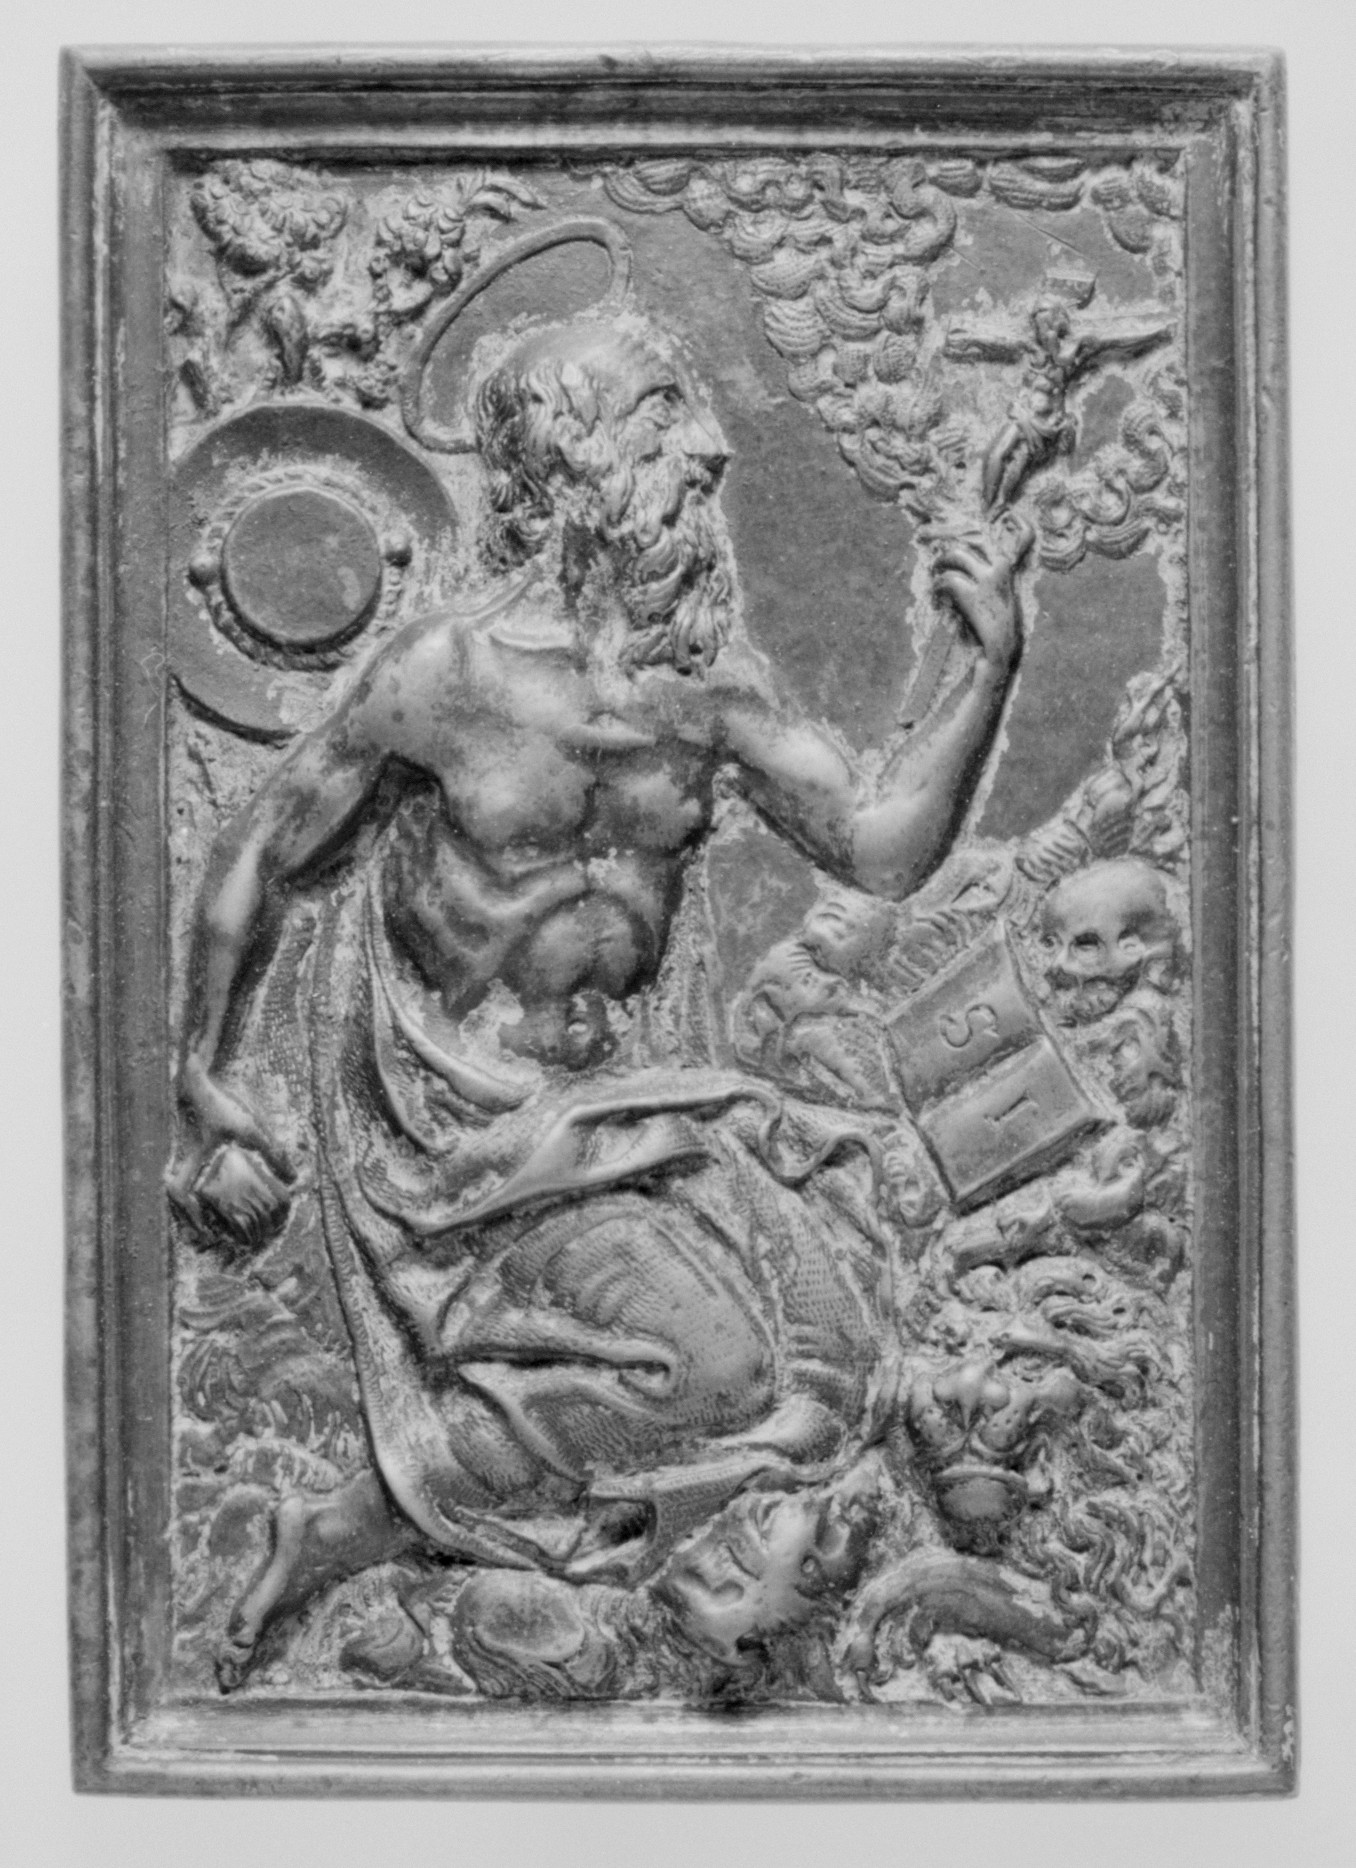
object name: plaquette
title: St. Jerome in the Wilderness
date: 1501-1600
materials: gilt bronze, paint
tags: saint jerome,cross